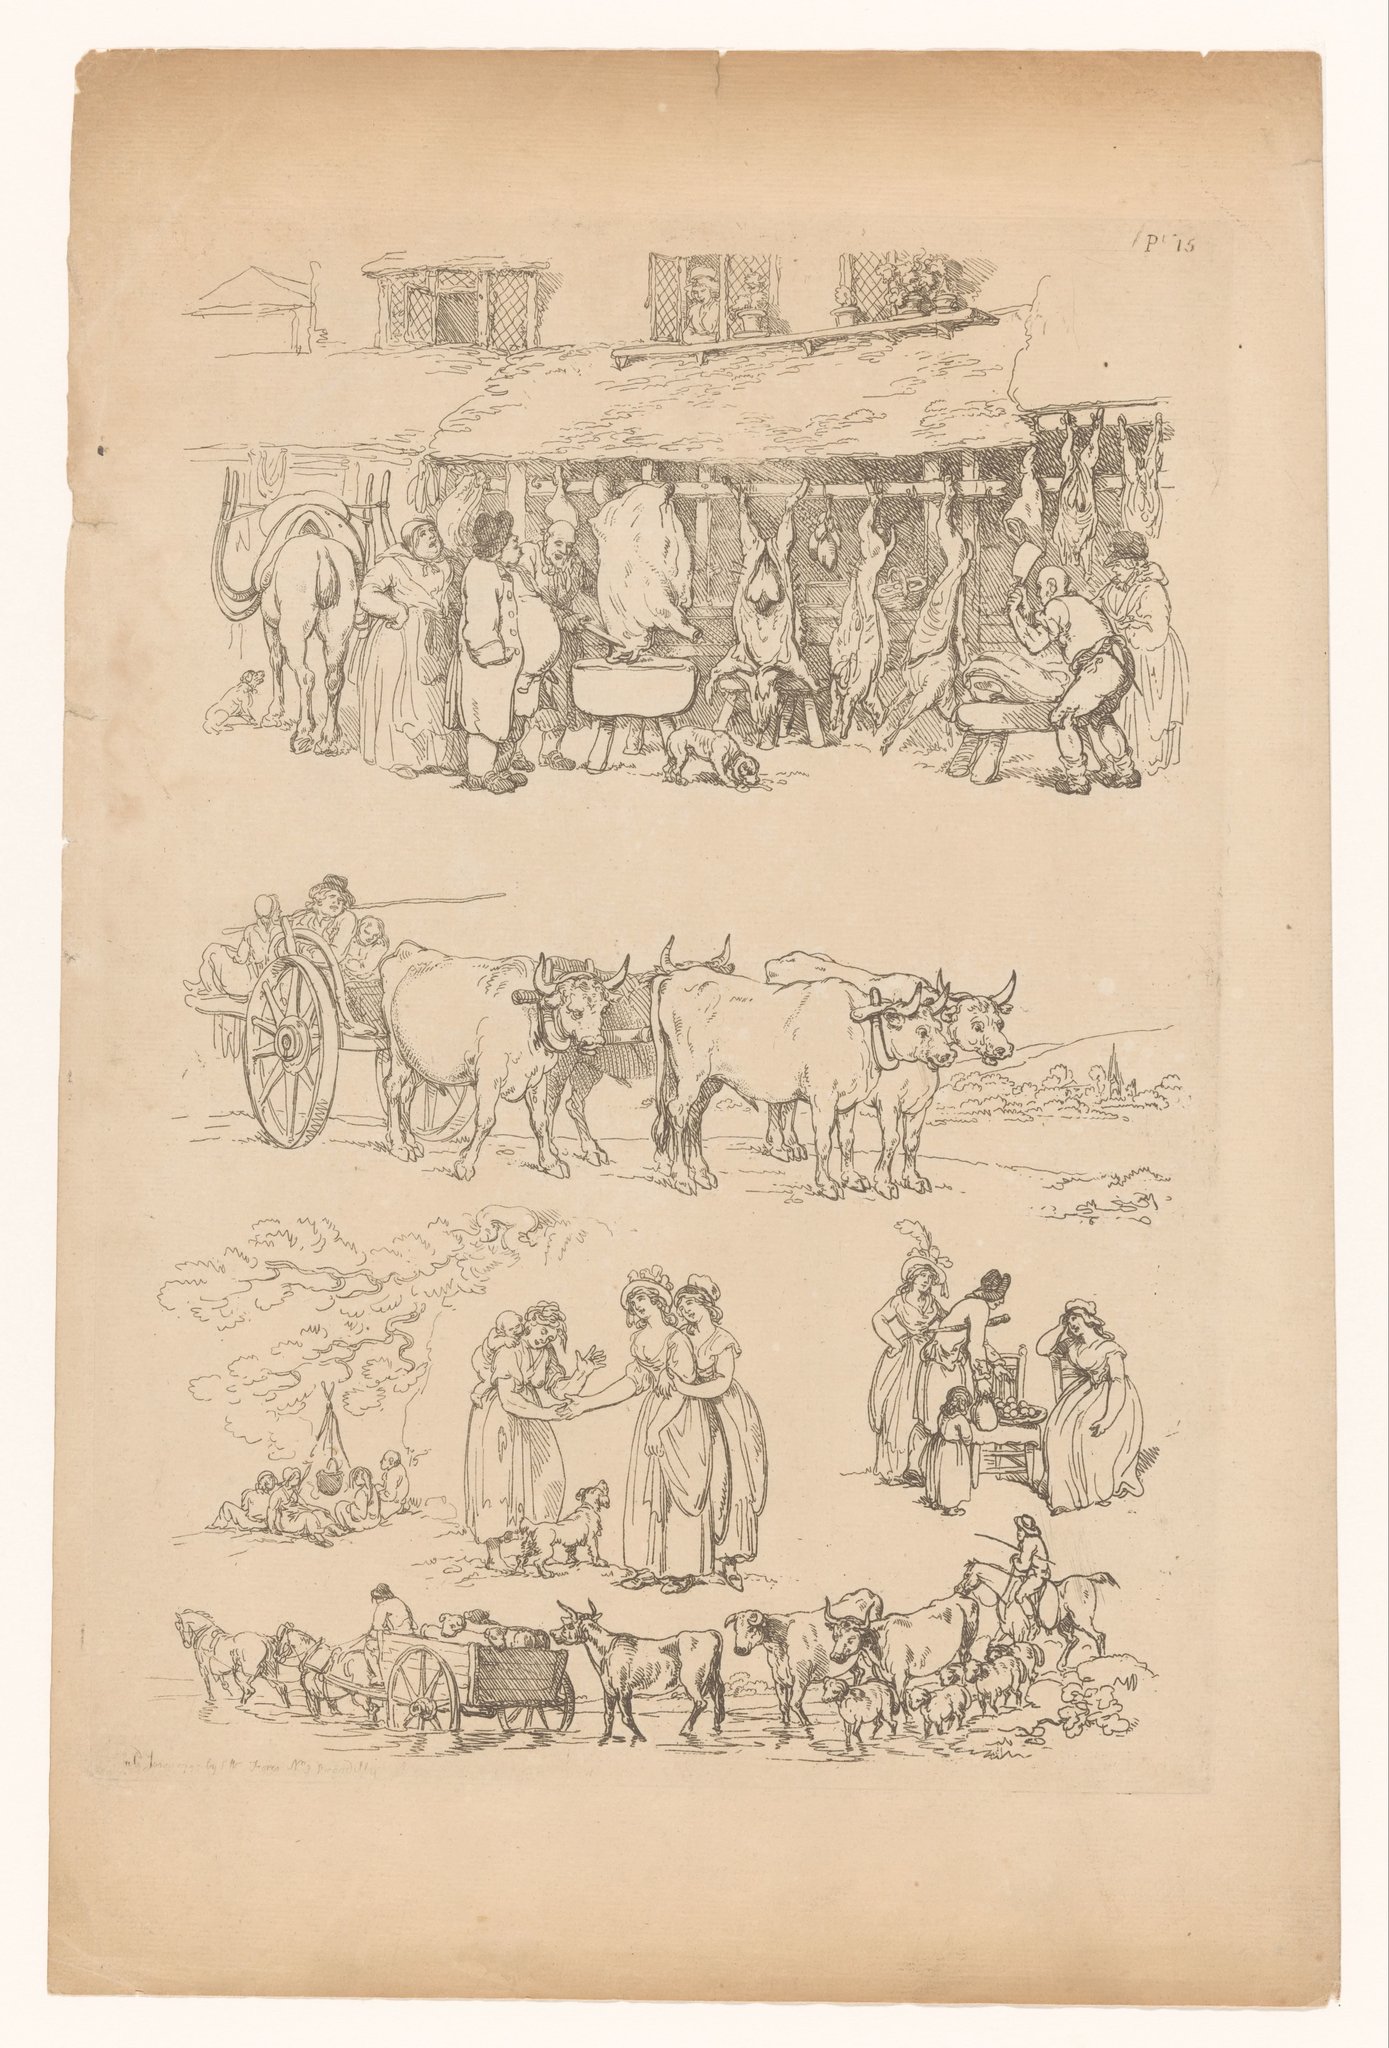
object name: print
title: Scènes uit het landleven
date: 1792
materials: paper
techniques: etching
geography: england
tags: country dwellers, butcher, slaughterman, rural life, political caricatures and satires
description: Blad met vijf verschillende scènes uit het leven op het platteland of in een dorp. Bovenaan de dorpsslager. Rechtsboven gemerkt: Pl. 15.